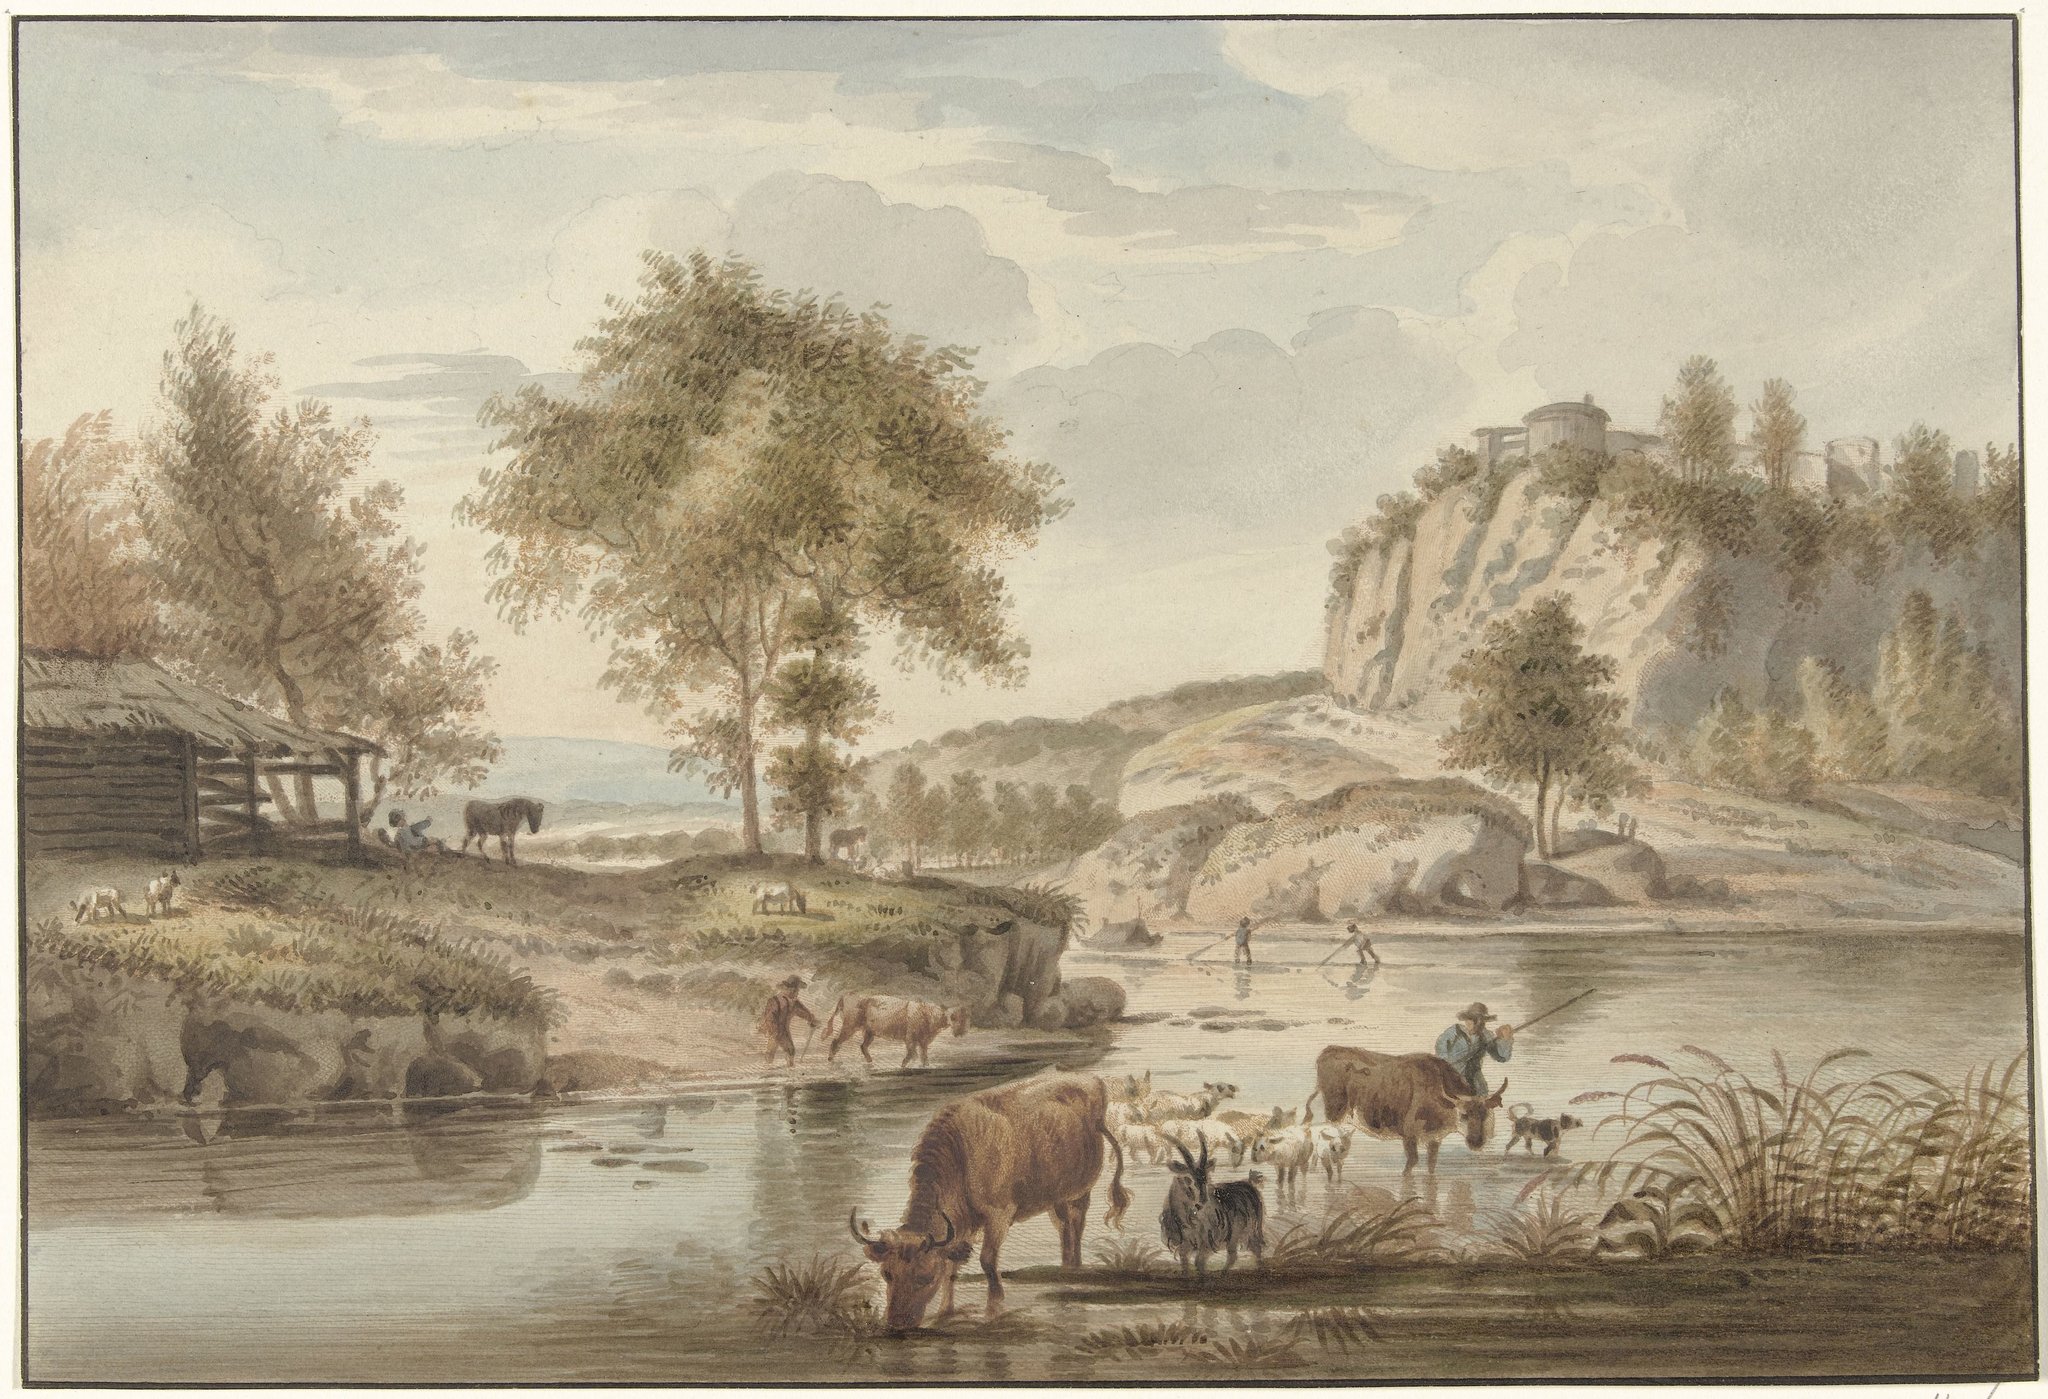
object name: print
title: Riviergezicht met vee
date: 1821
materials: paper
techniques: etching, hand coloring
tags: river (+ landscape with figures, staffage)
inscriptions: collector's mark: Lugt 2725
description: Door Christiaan Josi opgenomen in een uitgave met 100 werken naar Hollandse en Vlaamse meesters: Collection d'imitations de dessins d'après les principaux maîtres hollandais et flamands, Londen, C.Josi, 1821. Alle prenten in deze uitgave dragen op het verso het wapen van Cornelis Ploos van Amstel, de initiatiefnemer voor de uitgave.